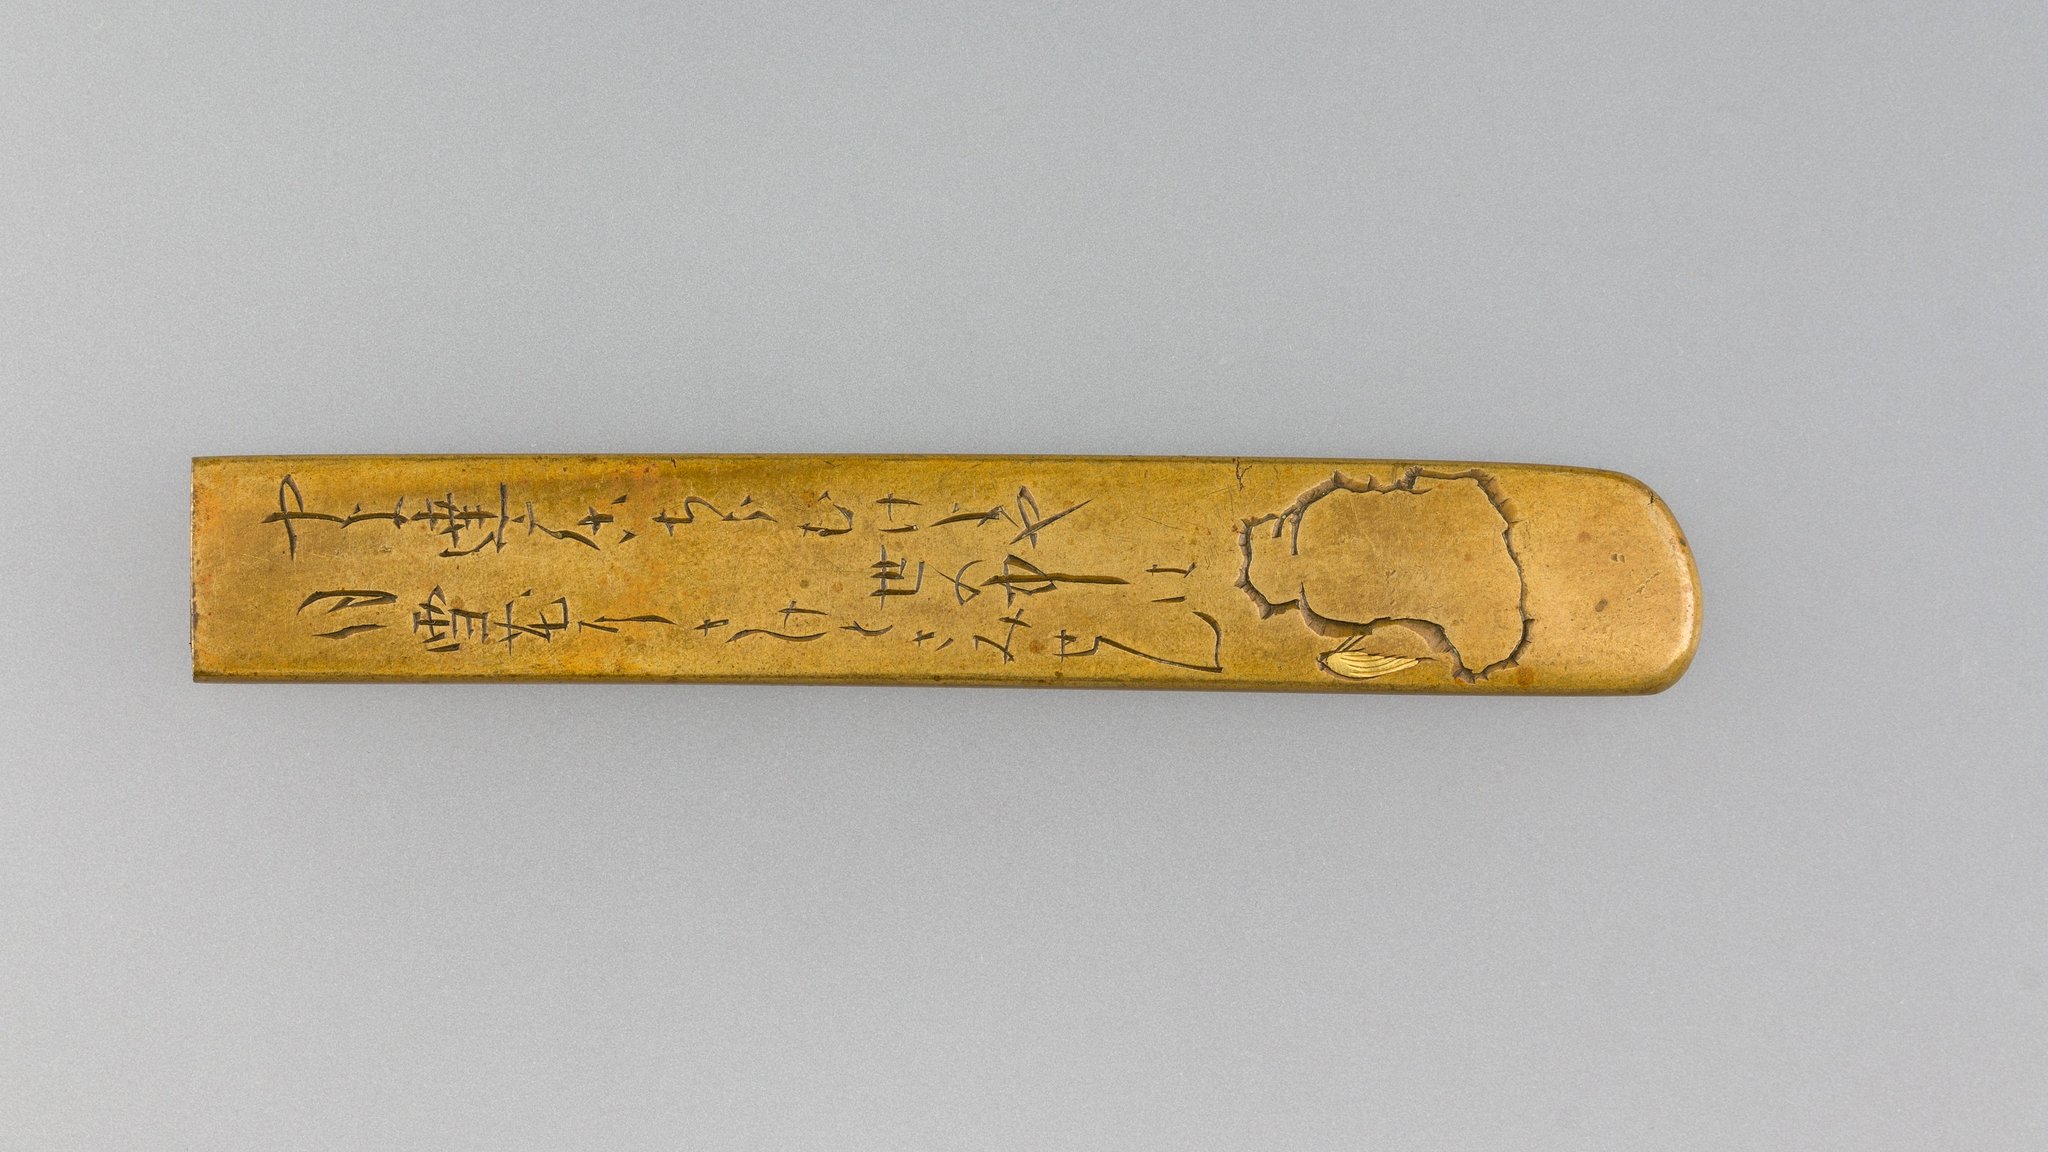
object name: knife handle kozuka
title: Knife Handle (Kozuka)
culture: japanese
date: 1800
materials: brass, silver alloy, gold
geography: japan